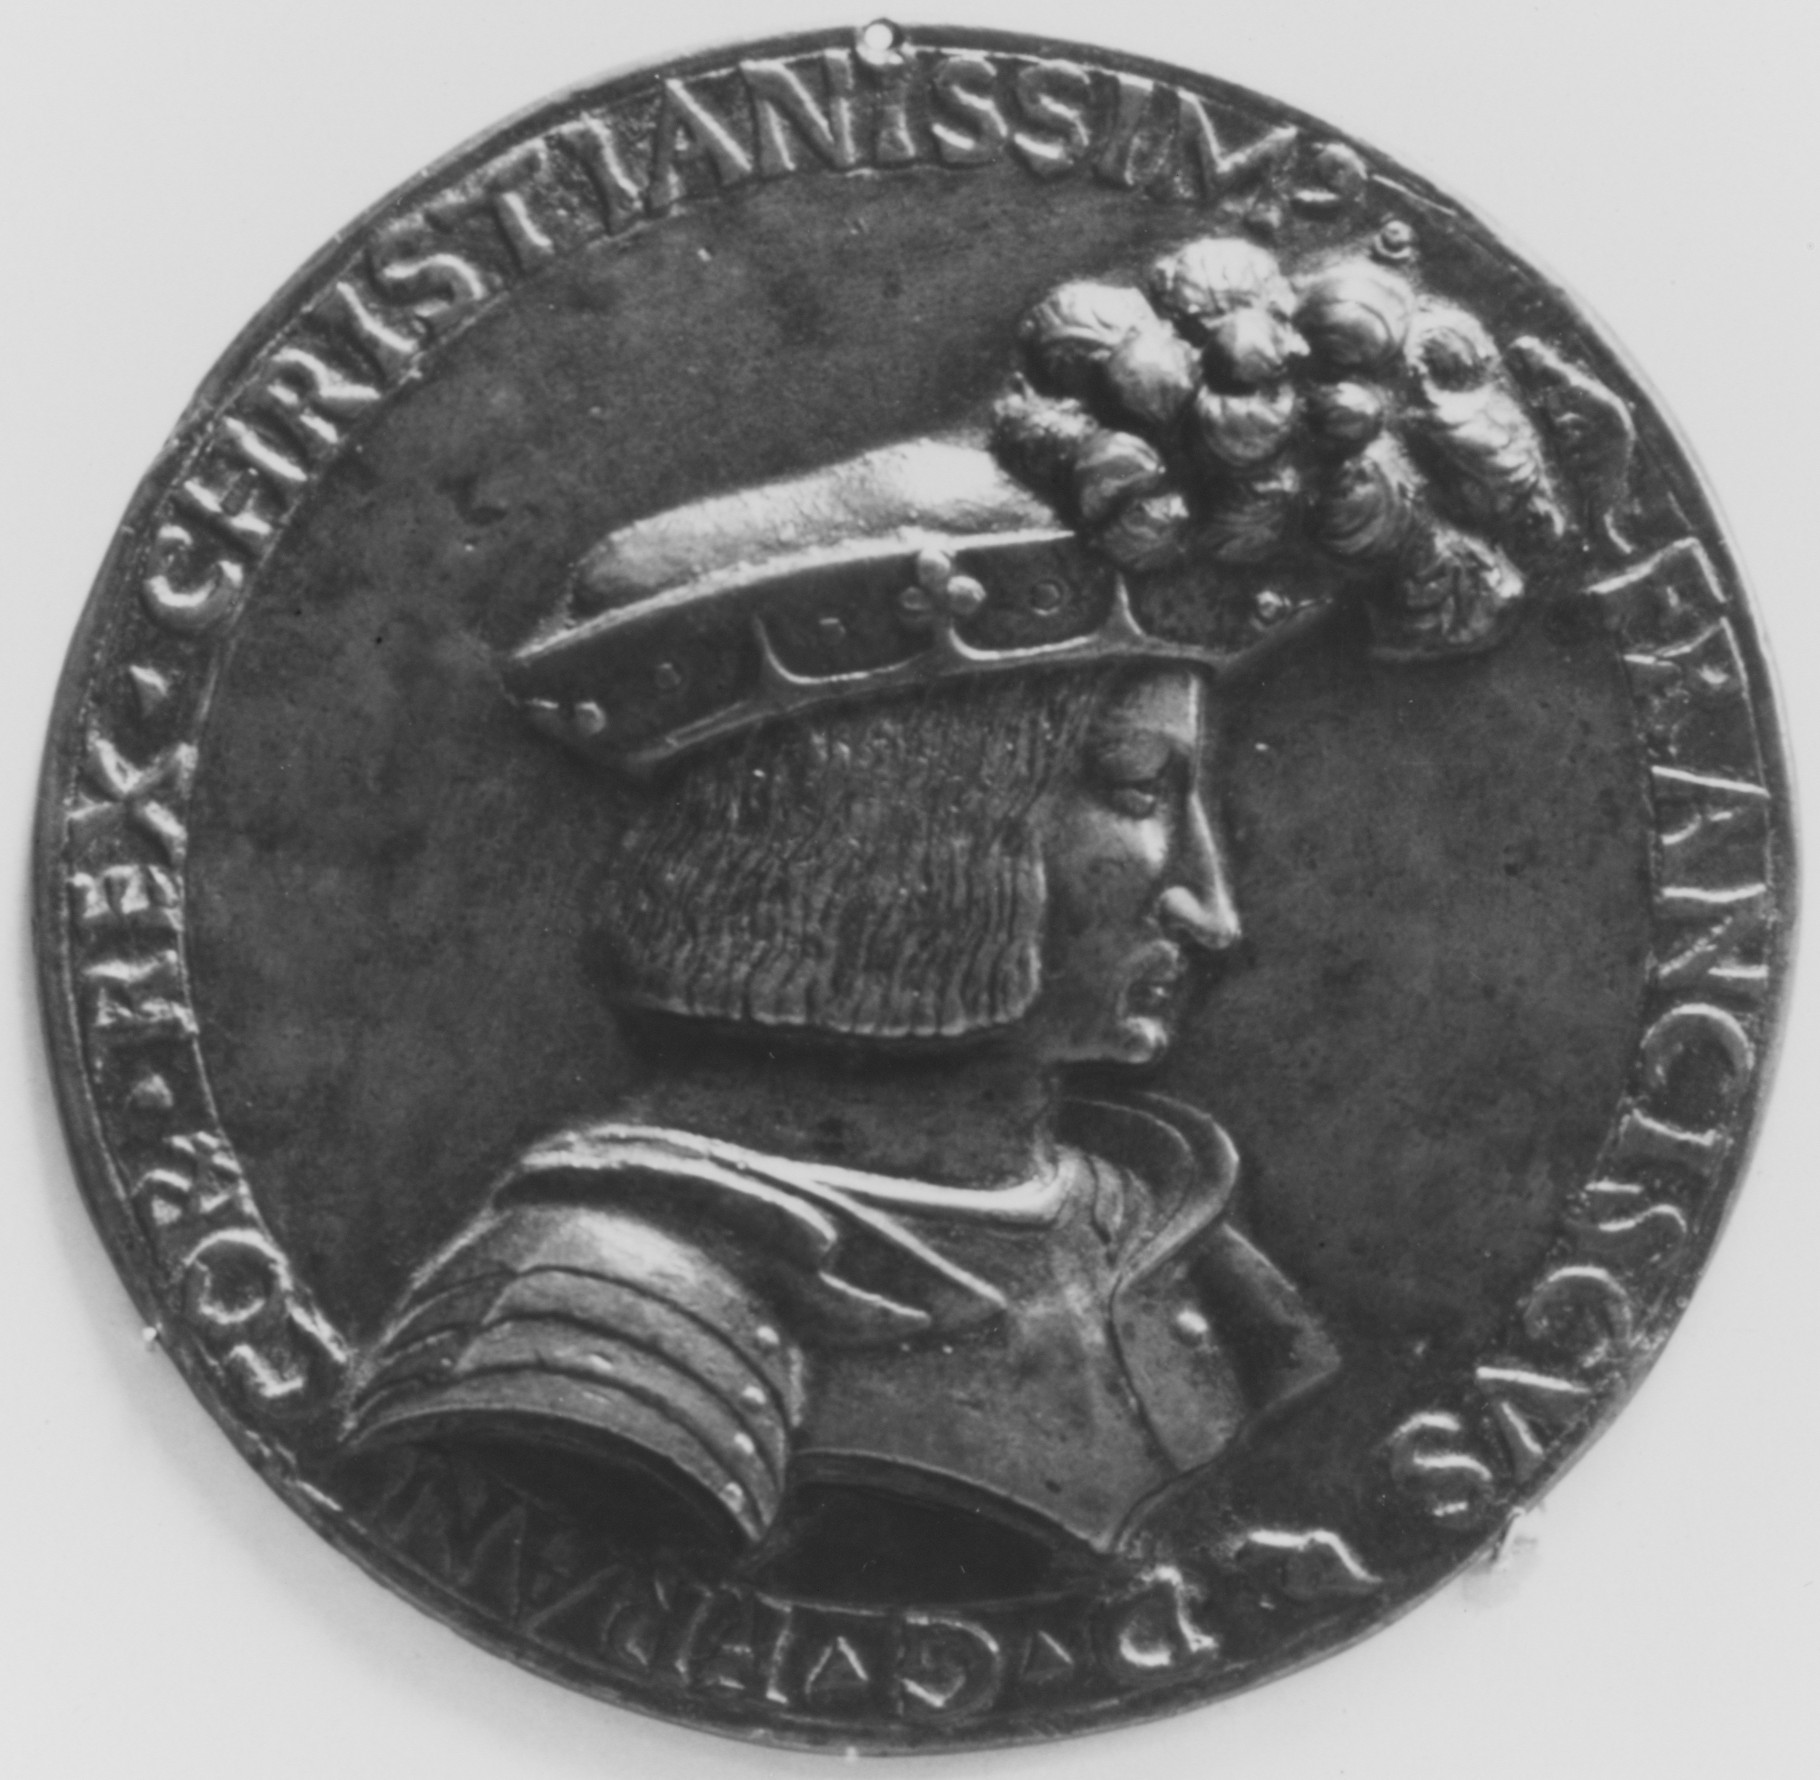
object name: medal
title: Francis I, King of France (1494–1547)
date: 1520-1530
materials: bronze, patina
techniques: casting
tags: men,profiles